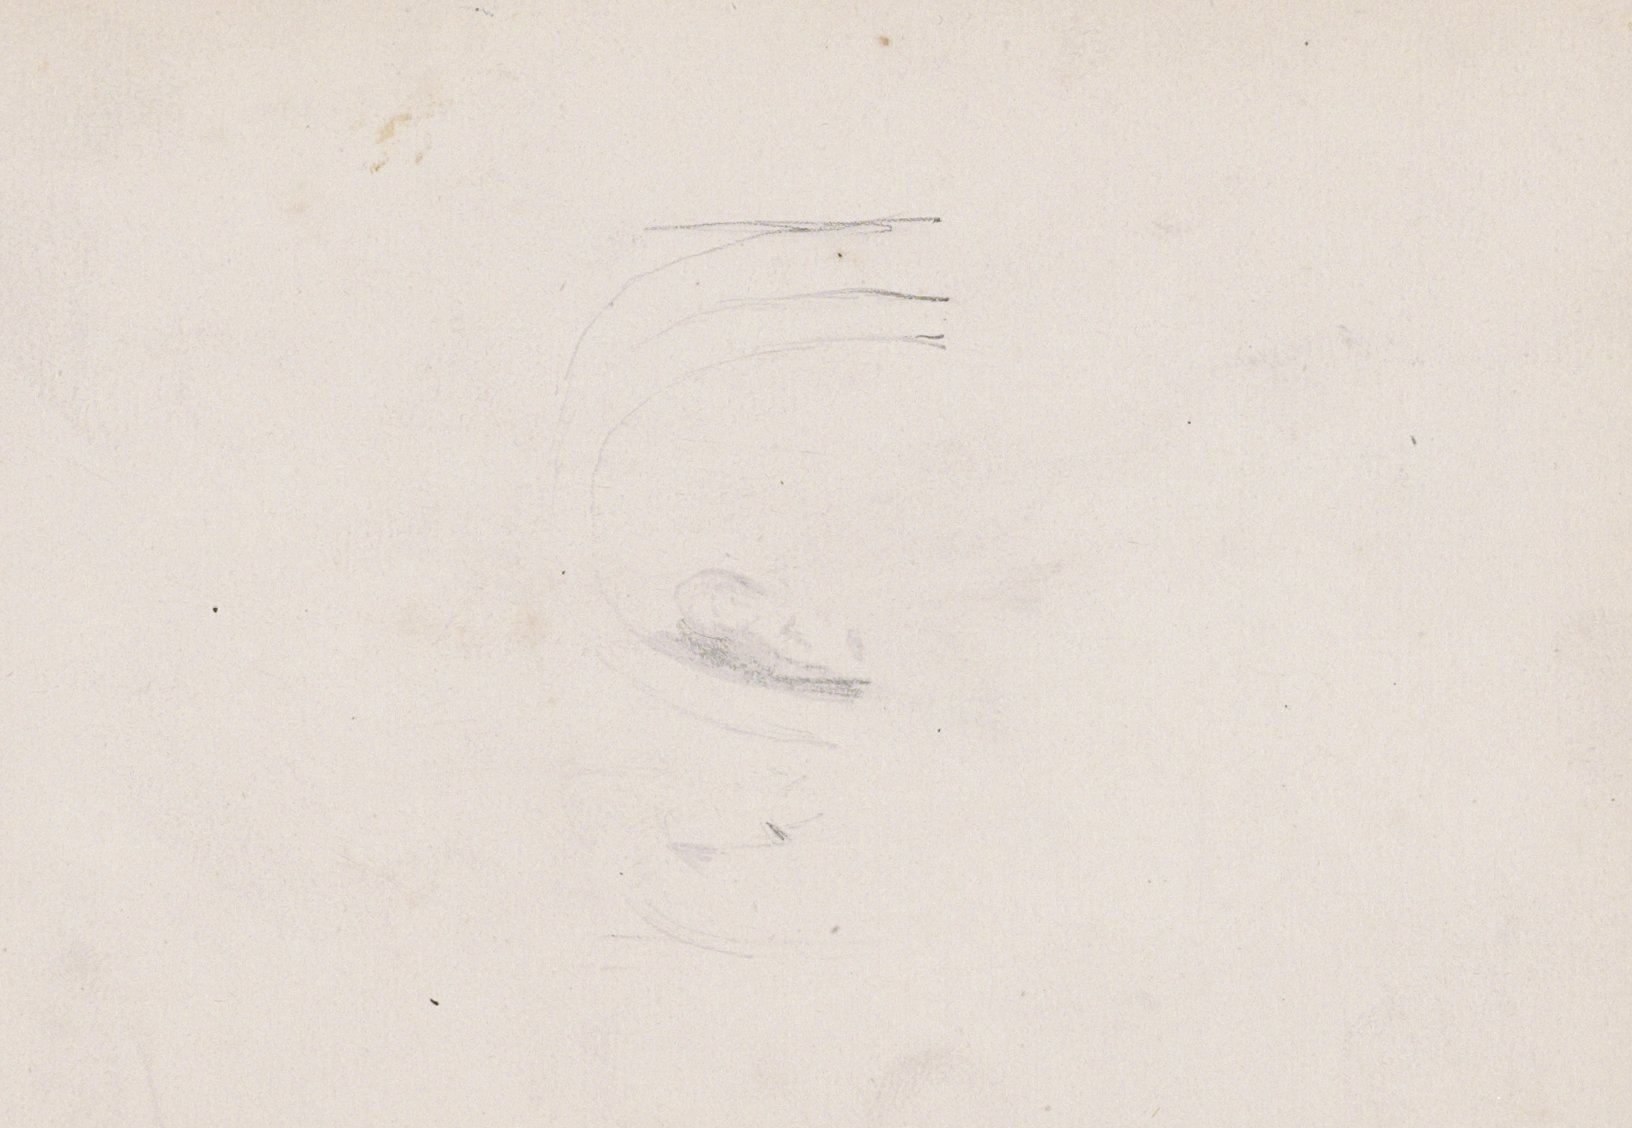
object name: sketchbook leaf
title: Studie, mogelijk een boog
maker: jac van looij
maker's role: draughtsman, painter, print maker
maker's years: 1855-1930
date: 1877-1880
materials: paper, pencil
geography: amsterdam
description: Blad 18 recto uit een schetsboek met 27 bladen.